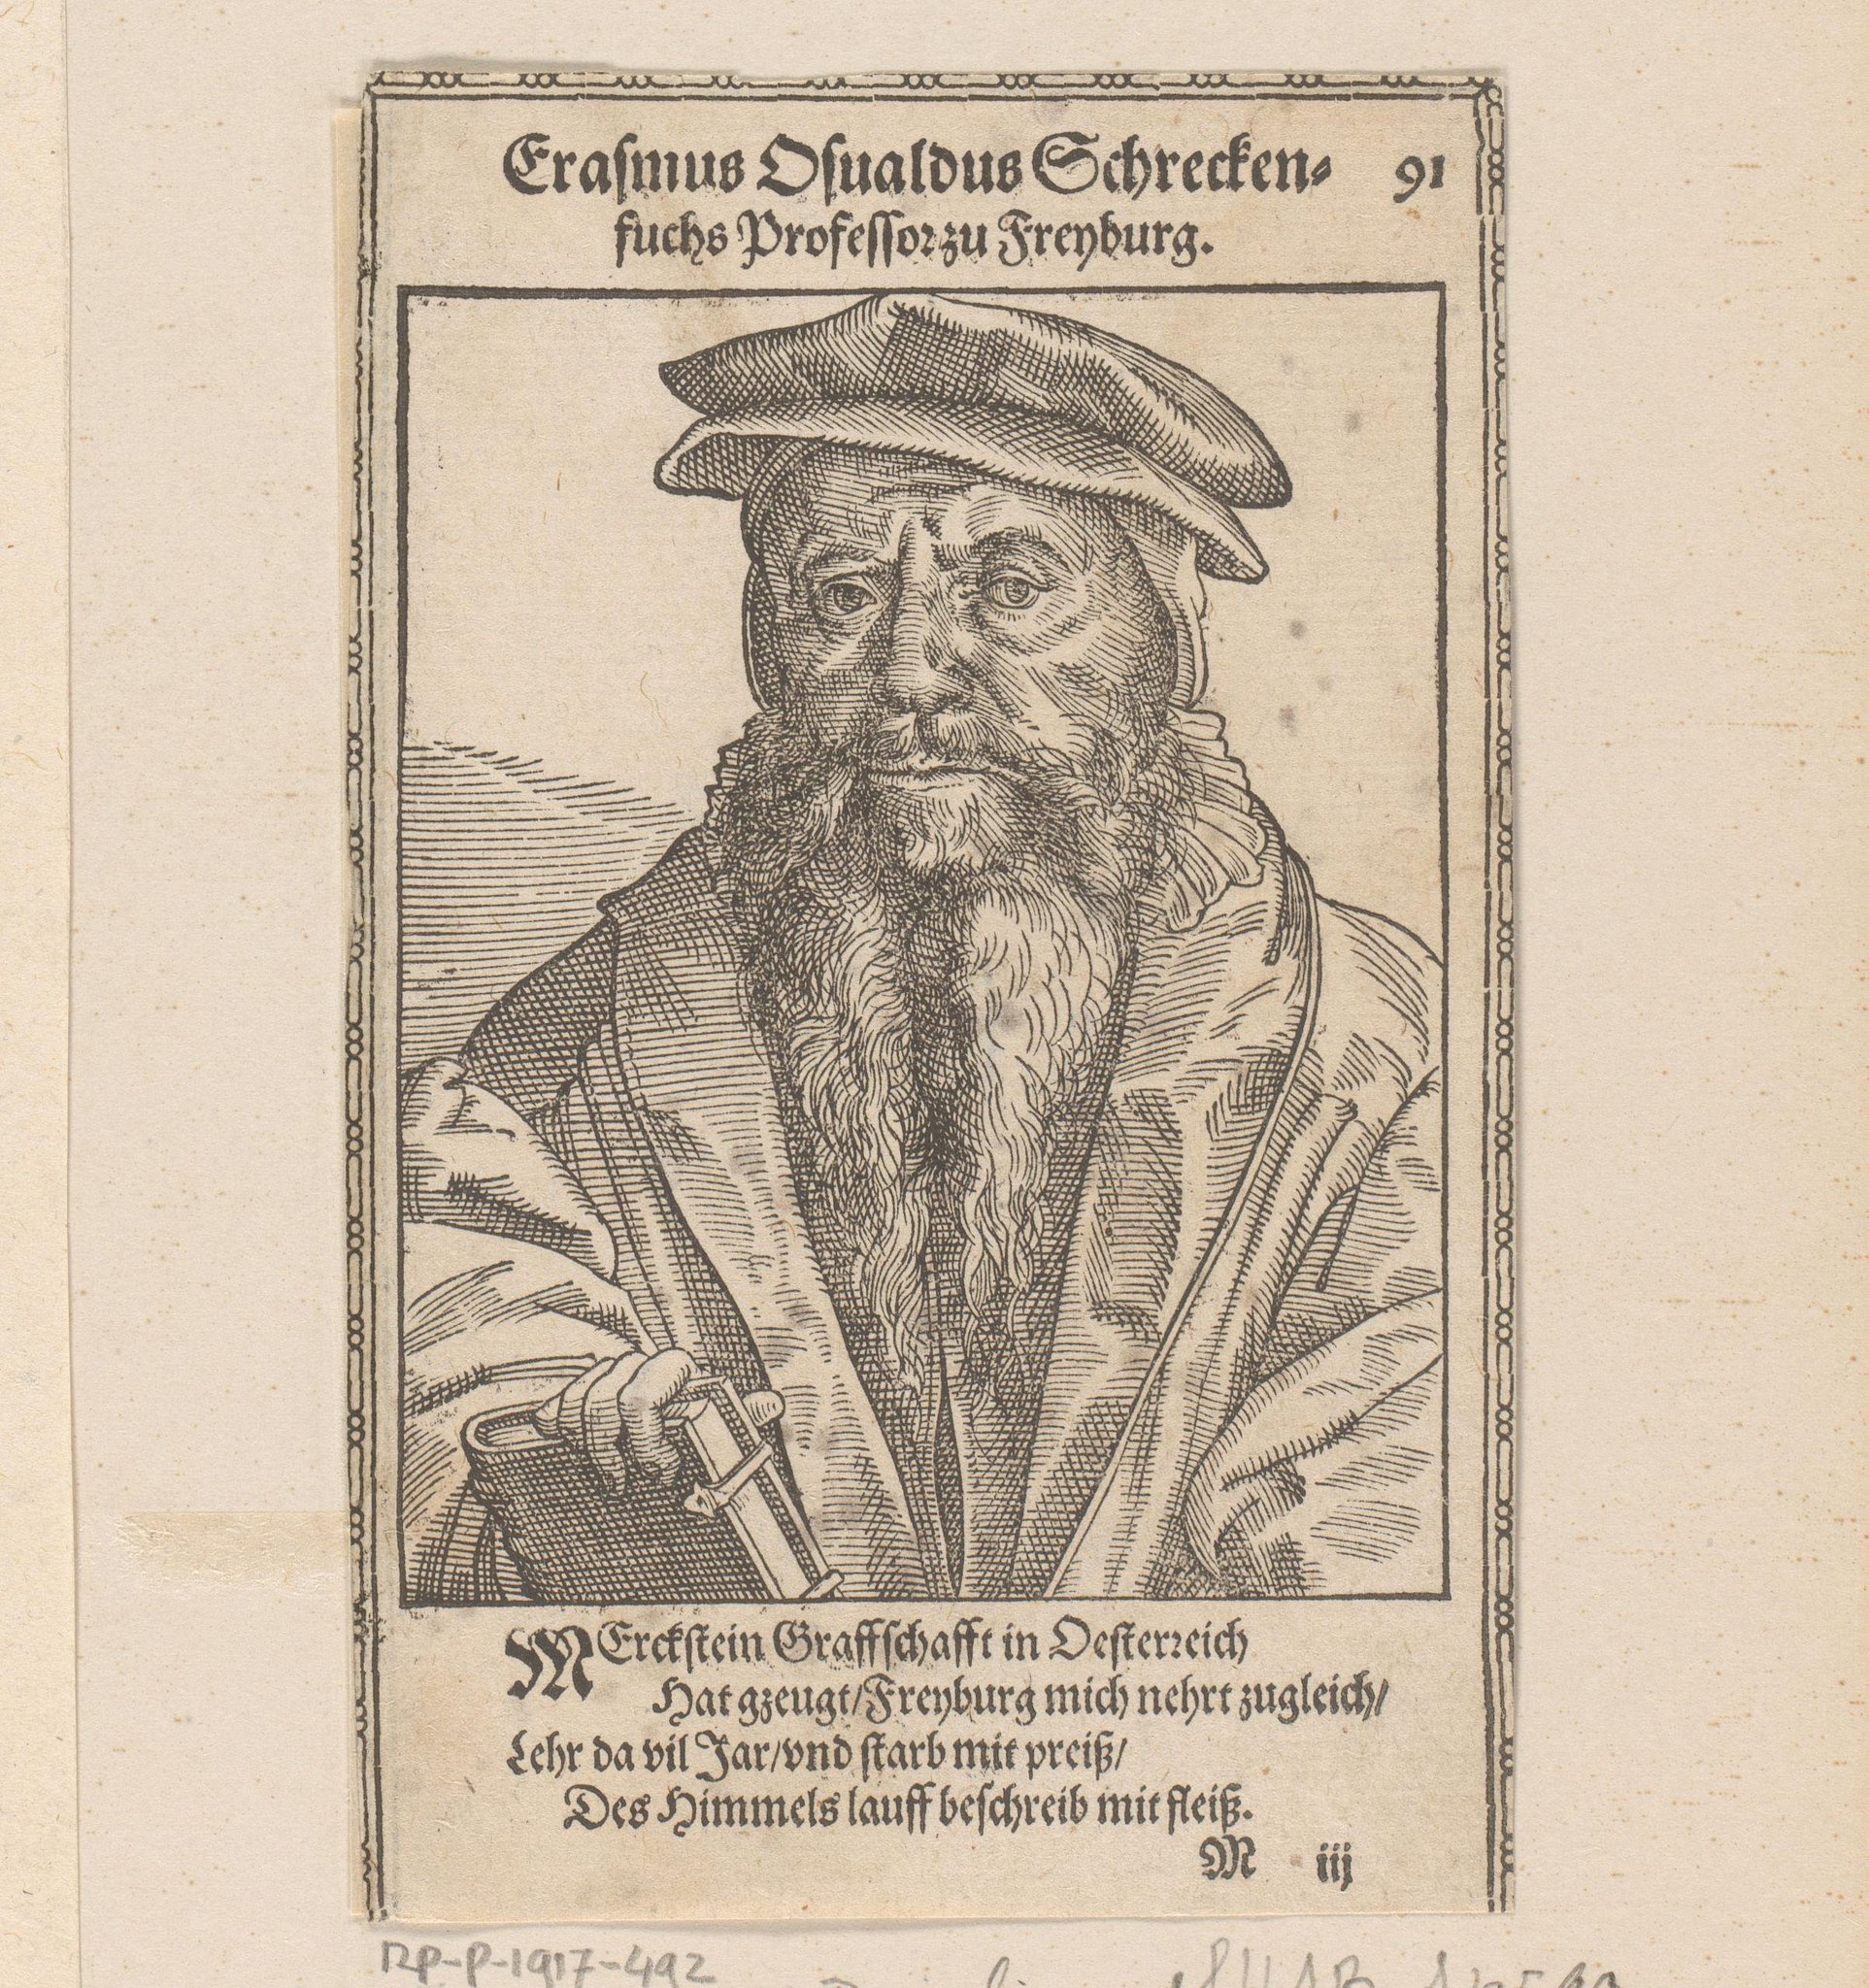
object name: print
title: Portret van Erasmus Oswald Schreckenfuchs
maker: bernhard jobin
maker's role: printer, publisher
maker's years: 1545-1593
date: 1587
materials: paper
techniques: letterpress printing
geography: straatsburg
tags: historical persons, mathematics (+ portrait of scholar, scientist)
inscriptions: collector's mark: Lugt 2228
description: Prent uit: Reusner, Nikolaus. Contrafacturbuch: ware und lebendige Bildnussen etlicher weitberhümbten unnd hochgelehten Männer in Teutschland. Straatsburg: Bernhard Jobin, 1587, f. 91. Prent ook gebruikt in de Latijnse editie, uitgegeven in hetzelfde jaar, en de 1590-editie. Prent ook gebruikt in latere publicaties.